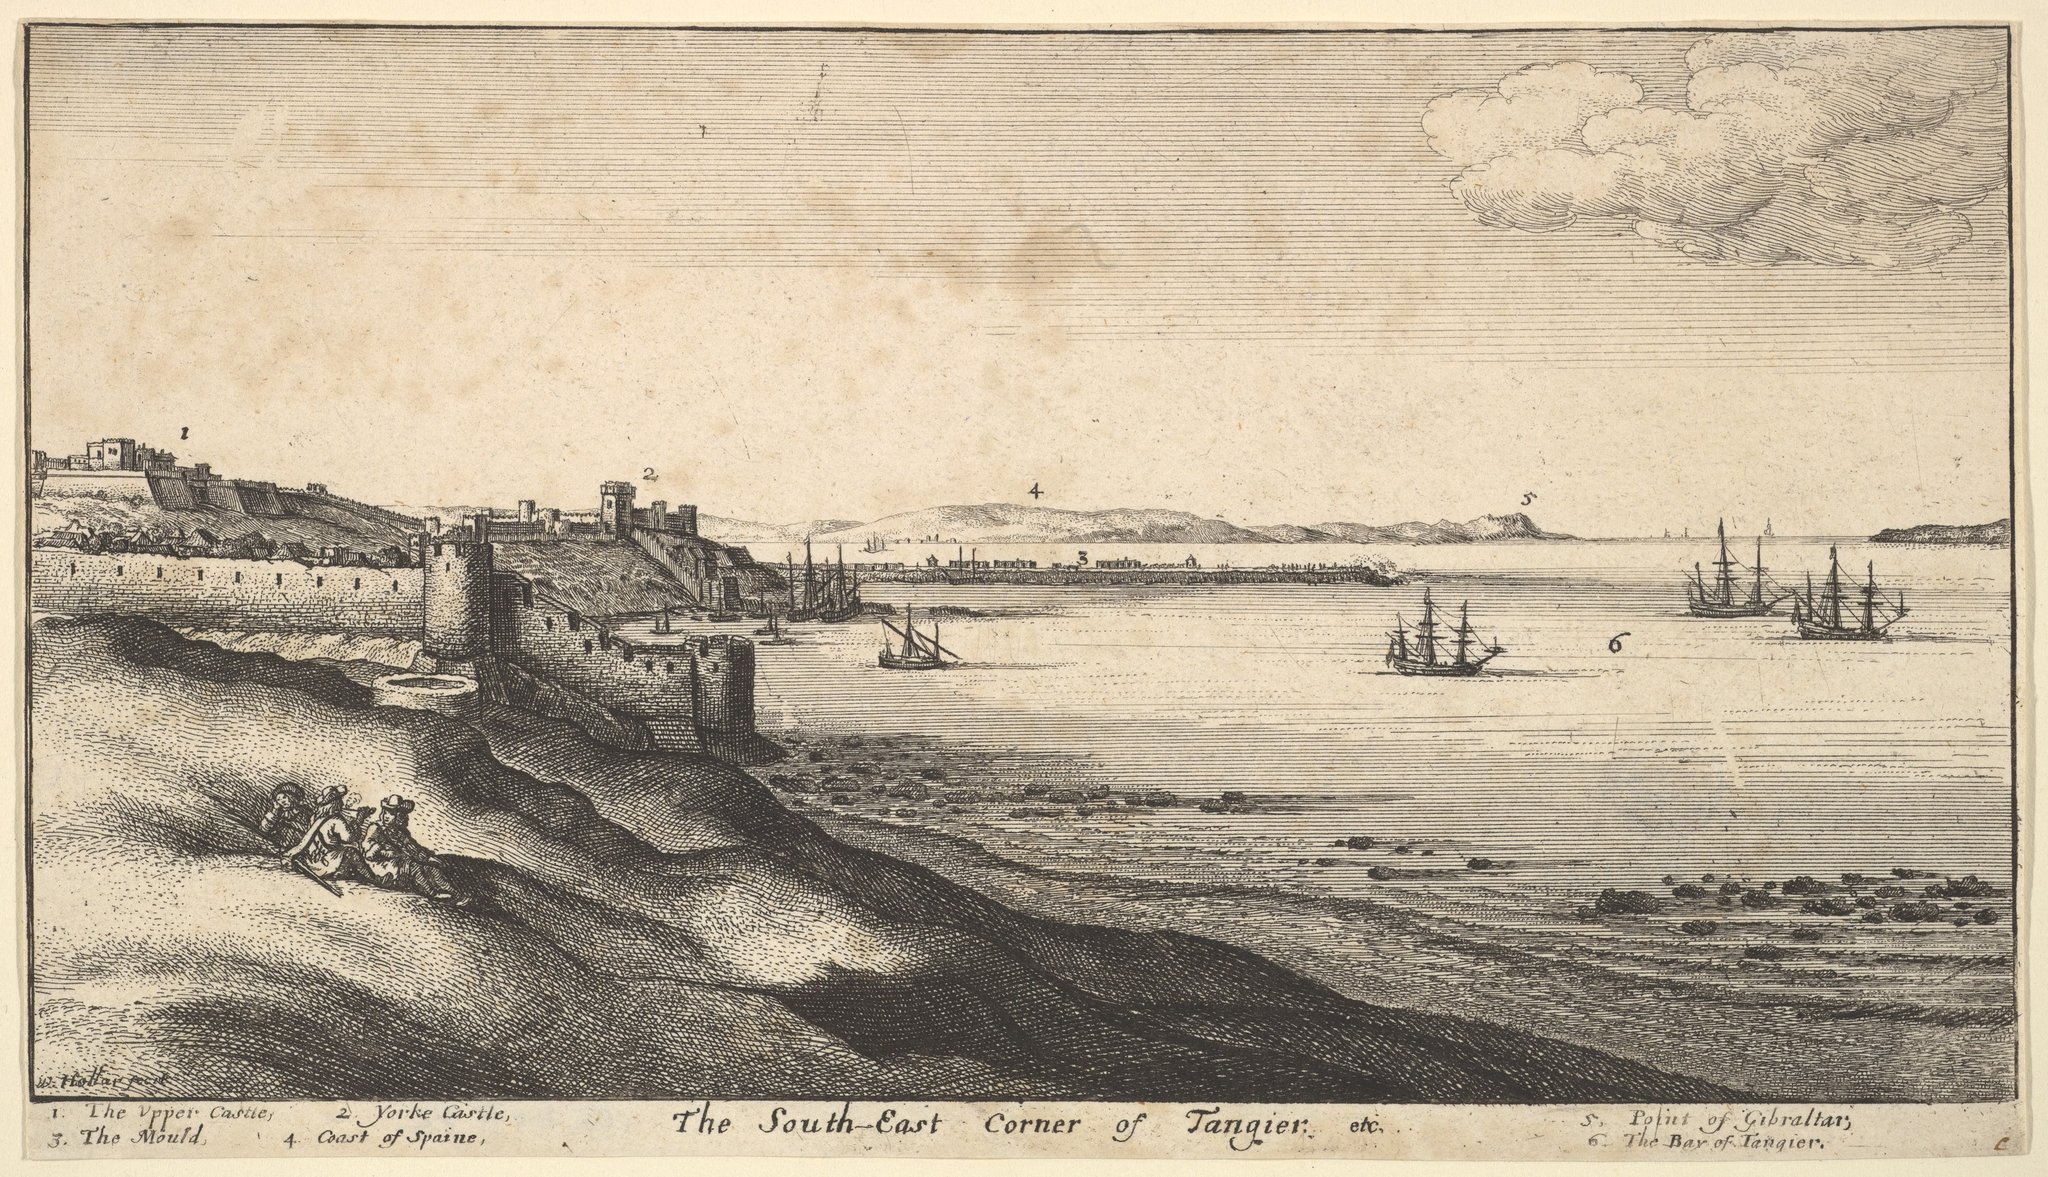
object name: print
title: South East Corner of Tangier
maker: wenceslaus hollar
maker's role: artist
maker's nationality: bohemian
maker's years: 1607-1677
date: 1669-1673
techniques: etching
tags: castles,landscapes,boats